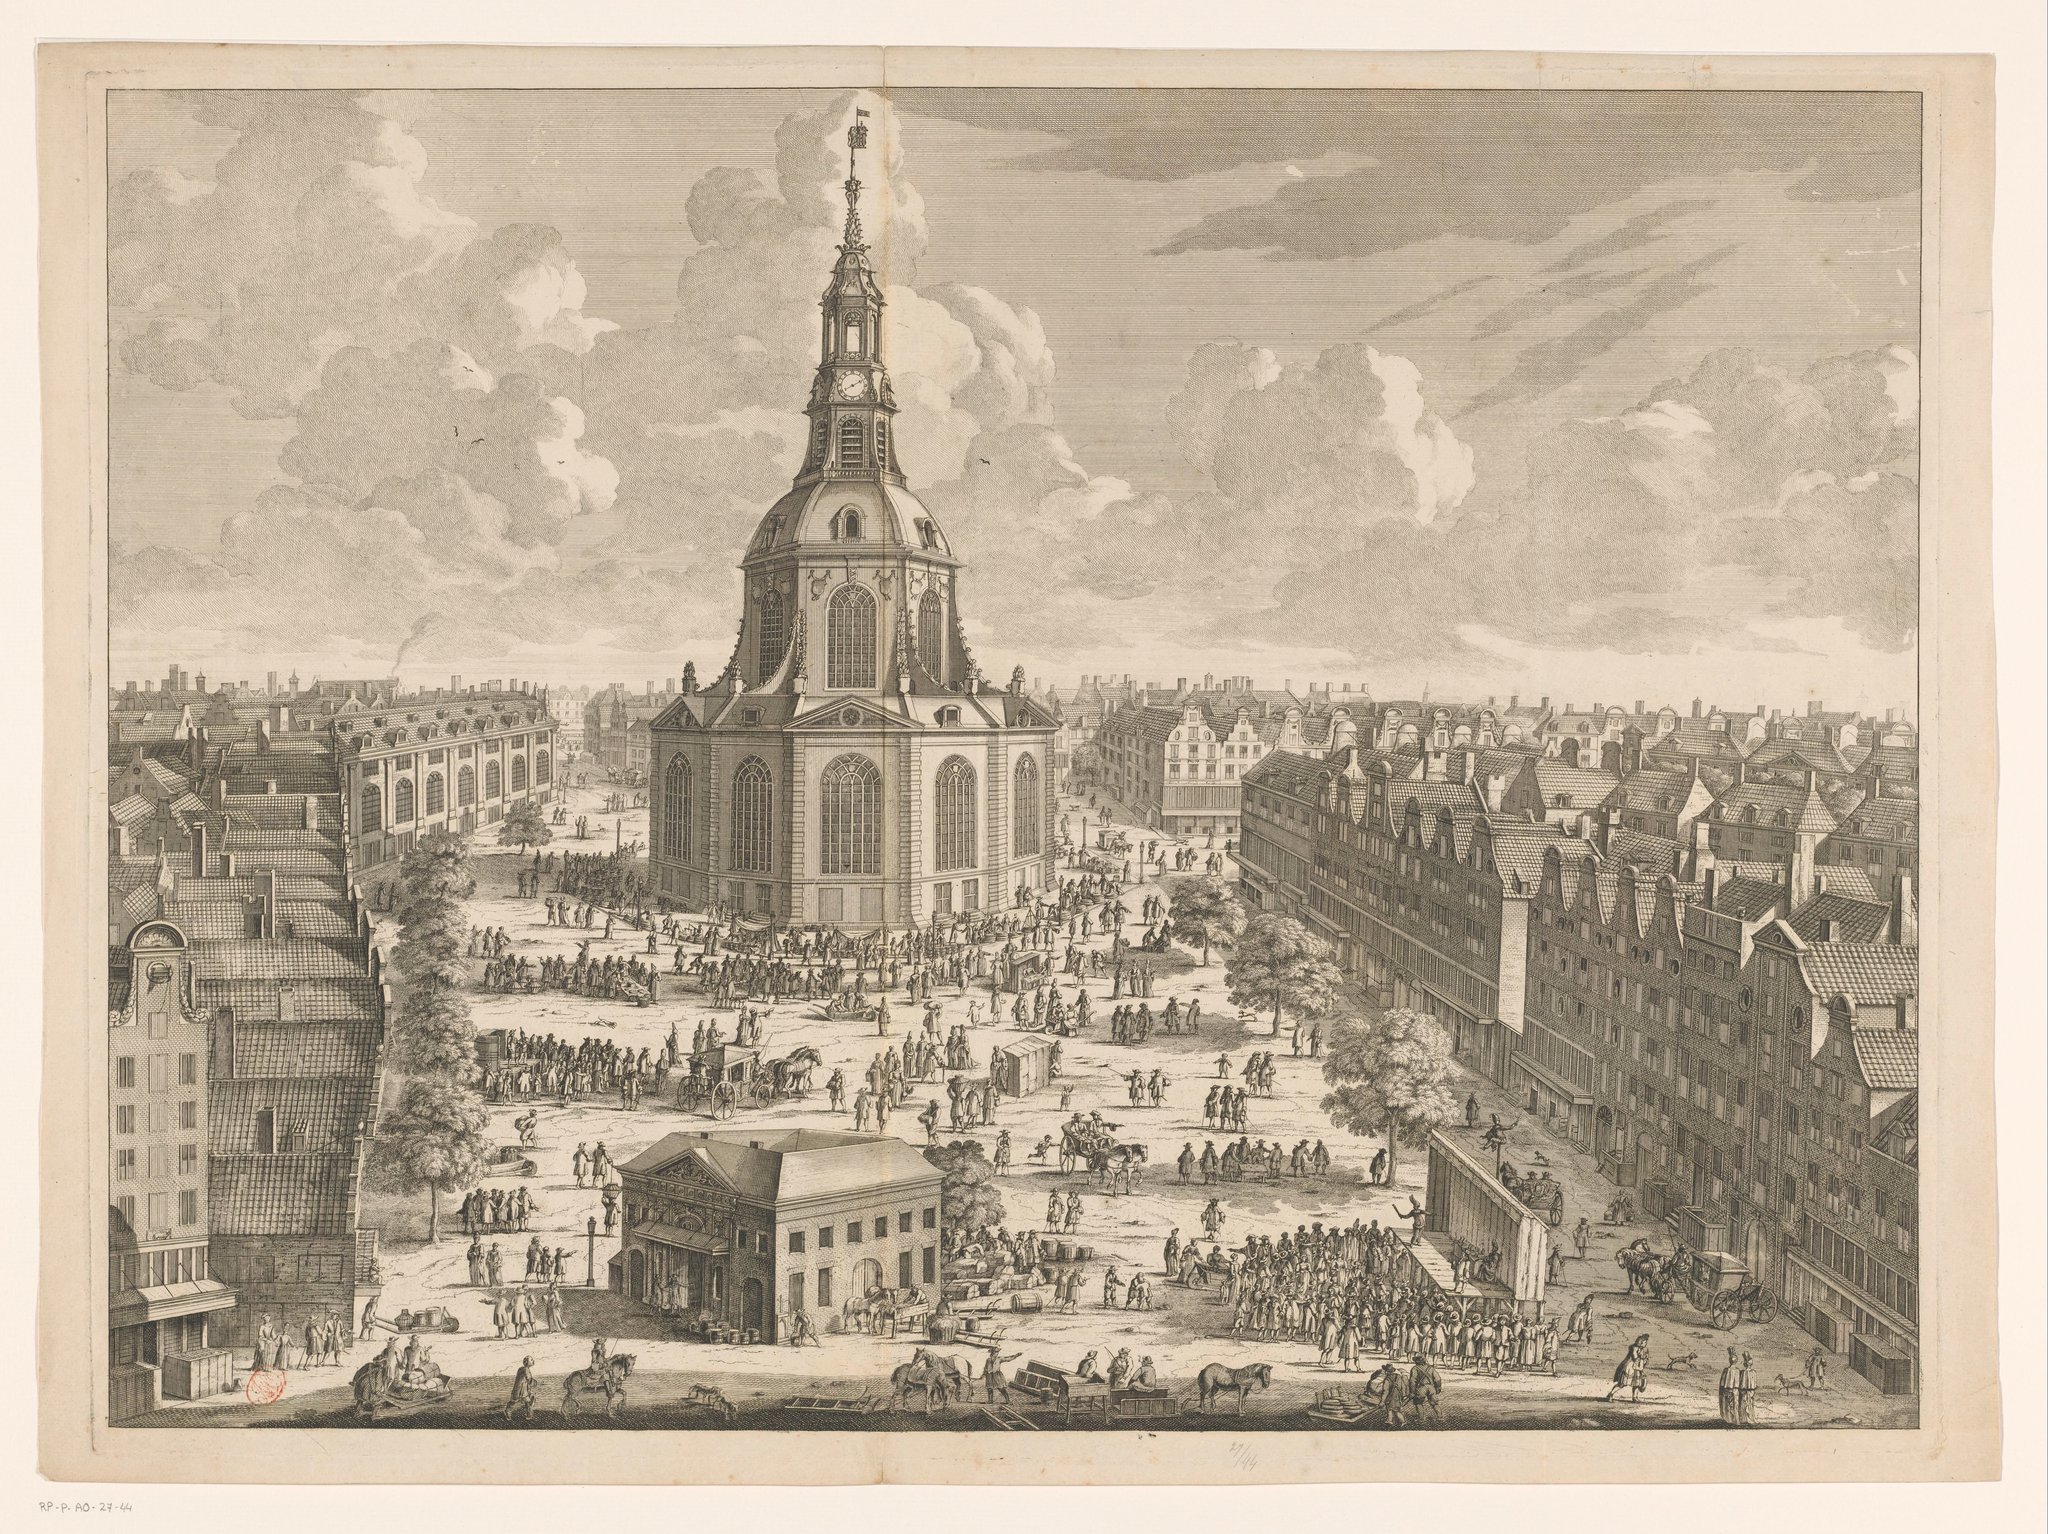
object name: print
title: Gezicht op de Botermarkt te Amsterdam met een nooit gebouwde koepelkerk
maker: daniël stopendaal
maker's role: print maker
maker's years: 1672-1726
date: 1700-1705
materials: paper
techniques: engraving, etching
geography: amsterdam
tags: buildings for performances - aa - open-air performances, stalls ~ theatre, etc. - aa - open-air performances, stall, booth (~ market), church (exterior), market, weigh-house, square, place, circus, etc. (+ city(-scape) with figures, staffage)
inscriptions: collector's mark: Lugt 195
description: Notaris, advocaat en kerkmeester van de Oude Kerk Nicolaas Listingh maakte rond 1700 een ontwerp voor een nieuwe koepelkerk op de Botermarkt (het huidige Rembrandtplein). Naast een houten maquette, die nog steeds te zien is in de Oude Kerk, liet hij ook op eigen kosten een serie van zeventien prenten van zijn ontwerp maken ('Nievv desseyn tot een Seer Groote, Stercke, en om te hooren, heel bequame Coupel-Kerck (…)'). De huidige prent is daar onderdeel van. Deze prenten zouden zijn gemaakt door Daniël Stopendaal.* De plaat van de huidige prent kwam later in het bezit van Isaac le Long of de uitgever van zijn boek Johannes van Septeren (I).* Zodoende is de tweede staat van deze prent (met toevoeging van de titel 'Afbeeldinge van een fraaye Coupel-Kerk, uytgevonden door Mr. Nicolaas Listing, advokaat, om op de Booter-markt alhier geplaatst te worden; beneffens de geheele Bootermarkt, en alle de omleggende huysen') ook verschenen in de hieronder genoemde publicatie. *Long, Isaac le. Historische beschryvinge van de reformatie der stadt Amsterdam (…). Amsterdam: Johannes van Septeren (I), 1729, p. 572.